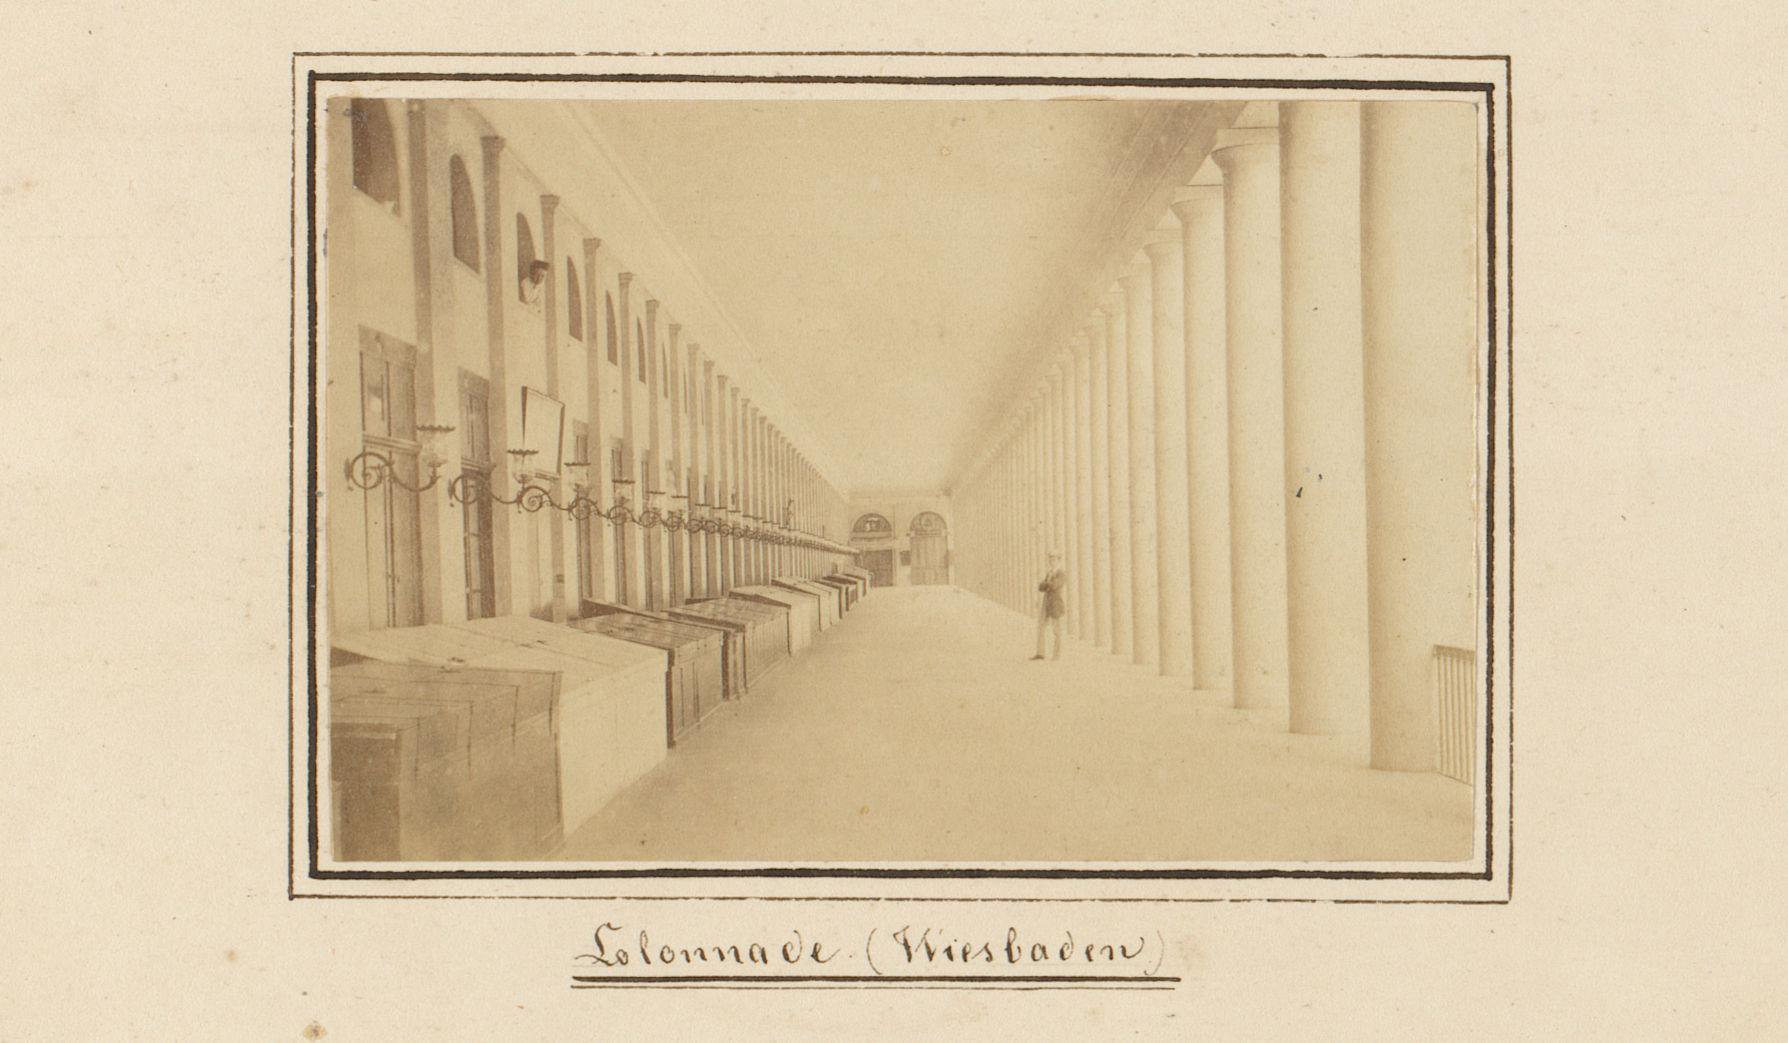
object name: photograph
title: Colonnade (Wiesbaden)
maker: Anonymous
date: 1870-1890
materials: paper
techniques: albumen print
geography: wiesbaden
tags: colonnade, watering-place, spa